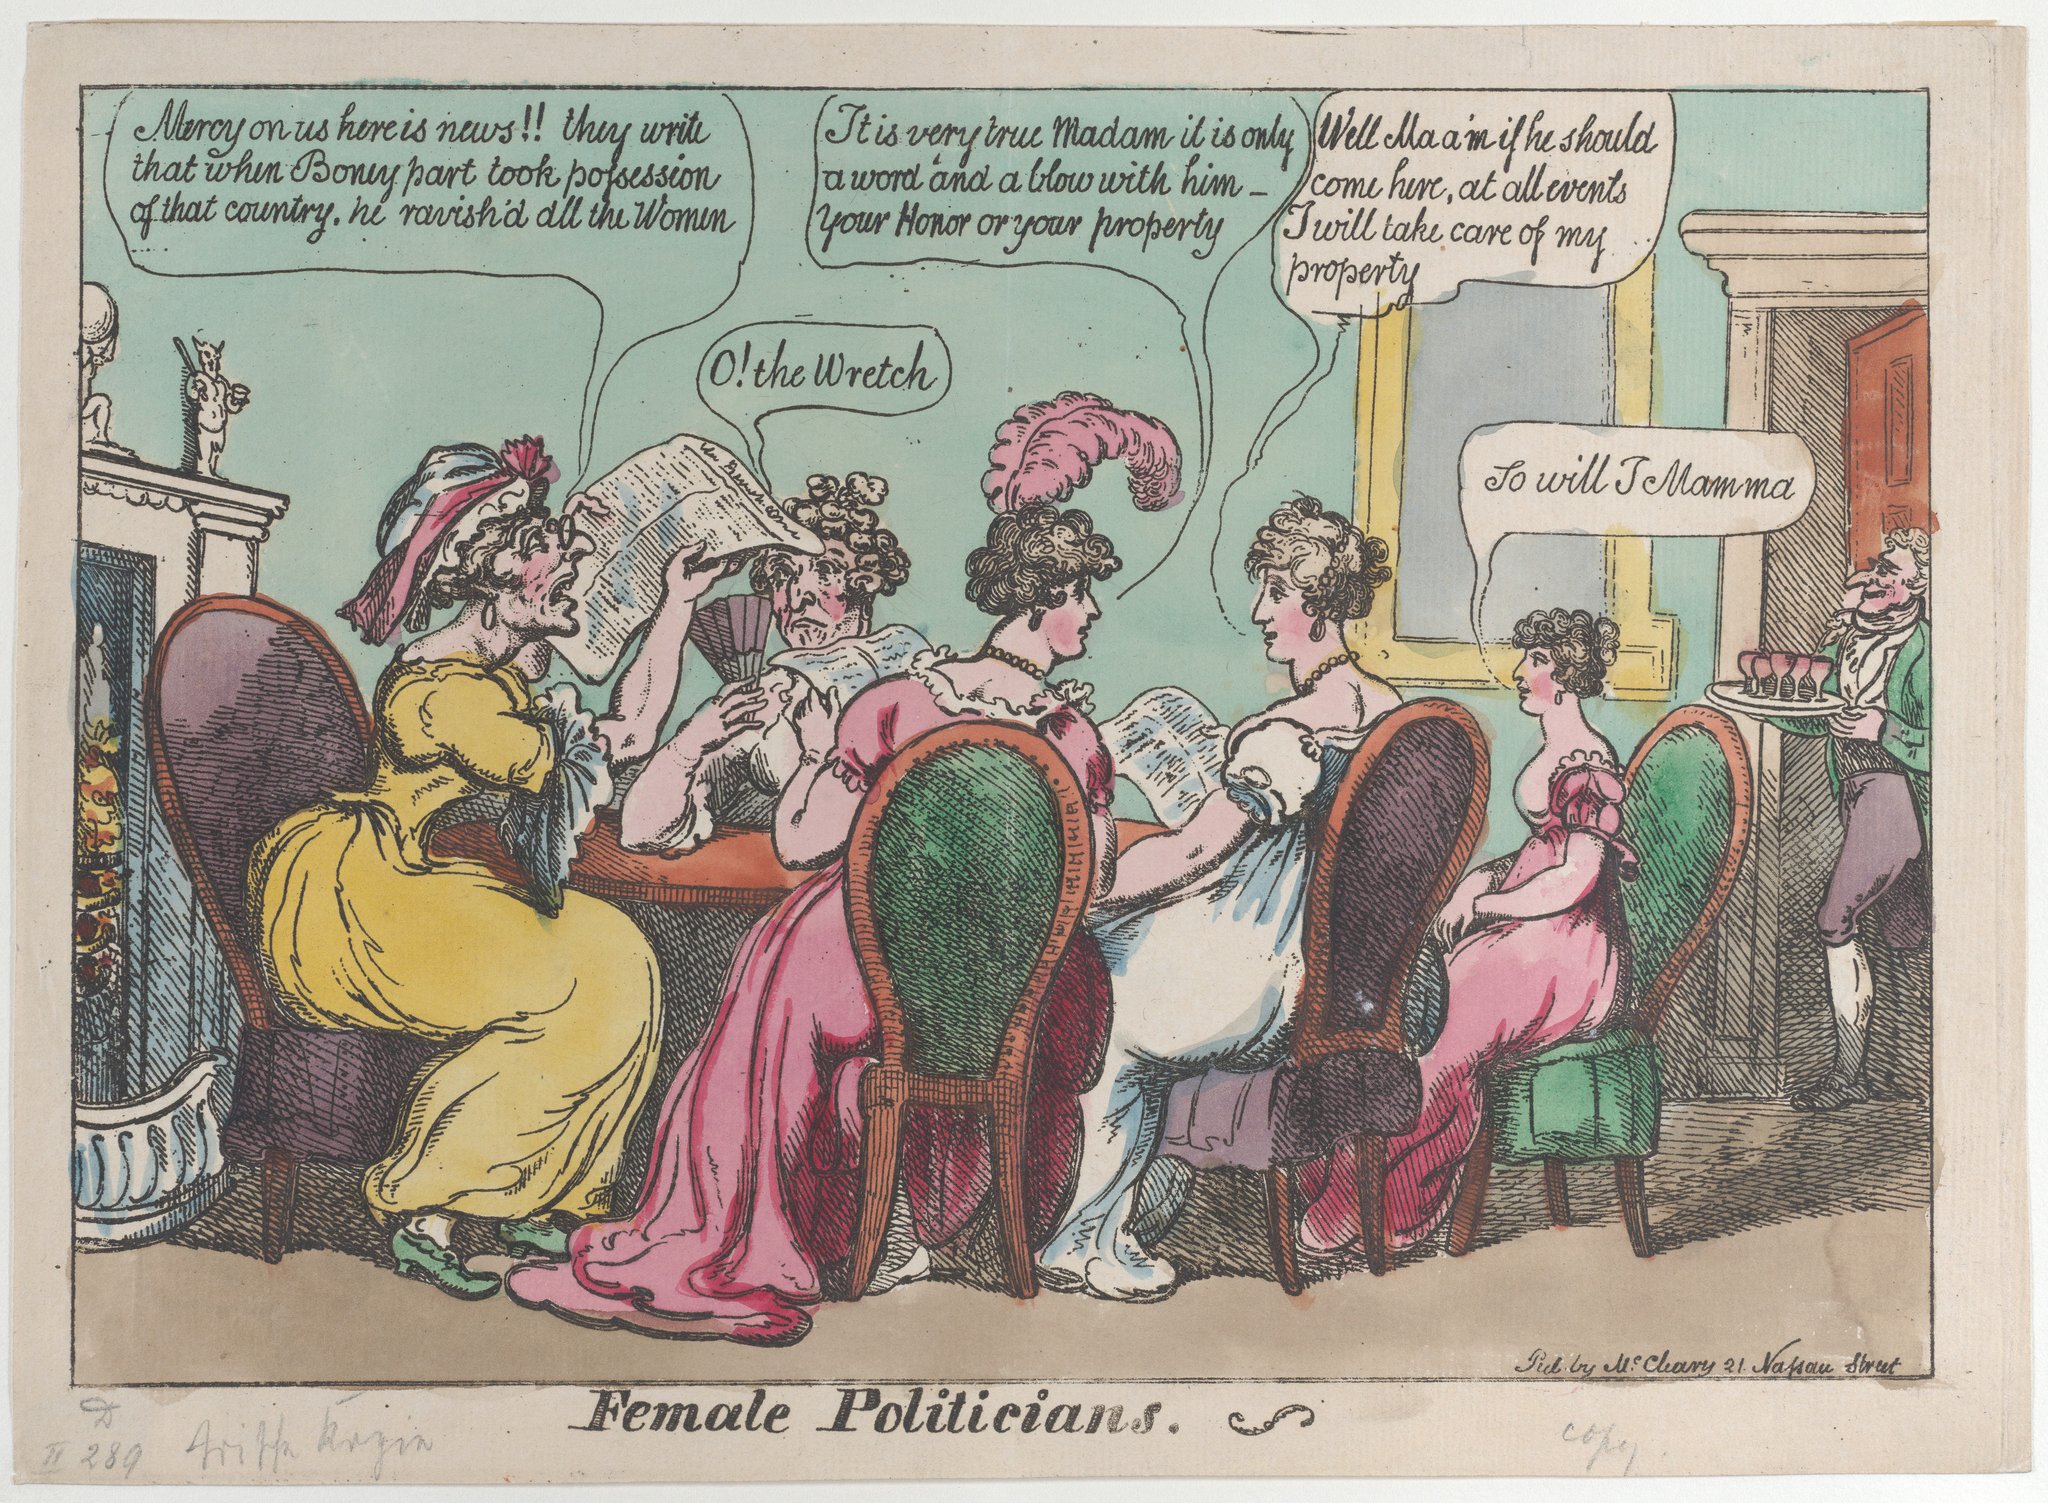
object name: print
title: Female Politicians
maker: thomas rowlandson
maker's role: artist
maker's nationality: british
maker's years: 1757-1827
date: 1815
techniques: etching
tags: satire,women,reading